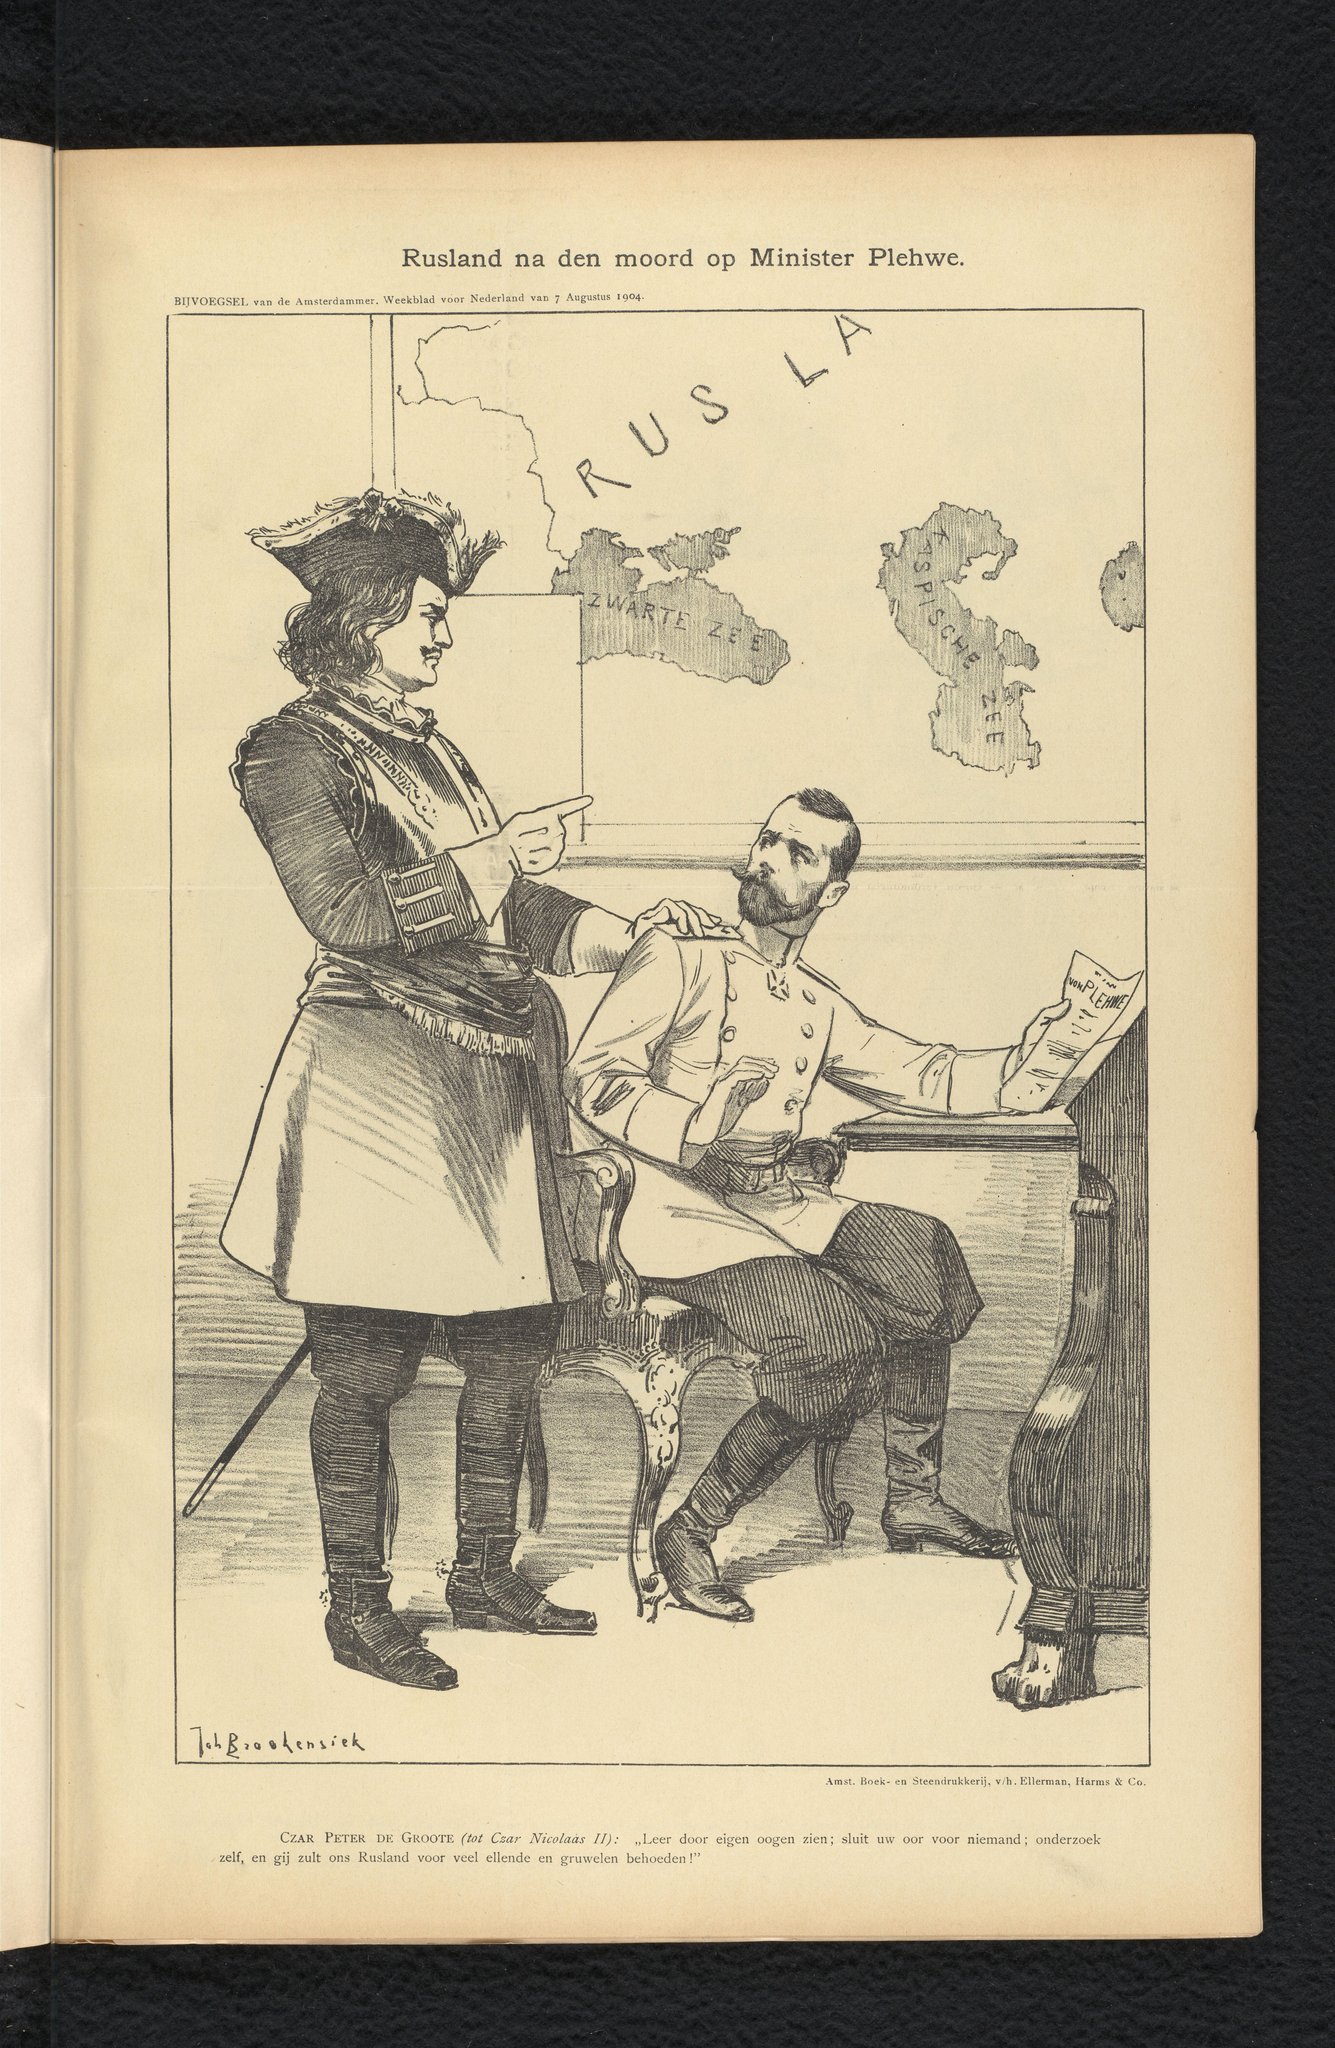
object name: cartoon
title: Rusland na den moord op Minister Plehwe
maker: johan braakensiek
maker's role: draughtsman, print maker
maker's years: 1858-1940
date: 1904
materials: paper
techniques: lithograph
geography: amsterdam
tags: peter i de grote (tsaar van rusland), political caricatures and satires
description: Tsaar Peter de Grote adviseert Nicolaas II waakzaamheid, naar aanleiding van de moord op de Russische politicus Vjatsjeslav von Plehve op 28 juli.